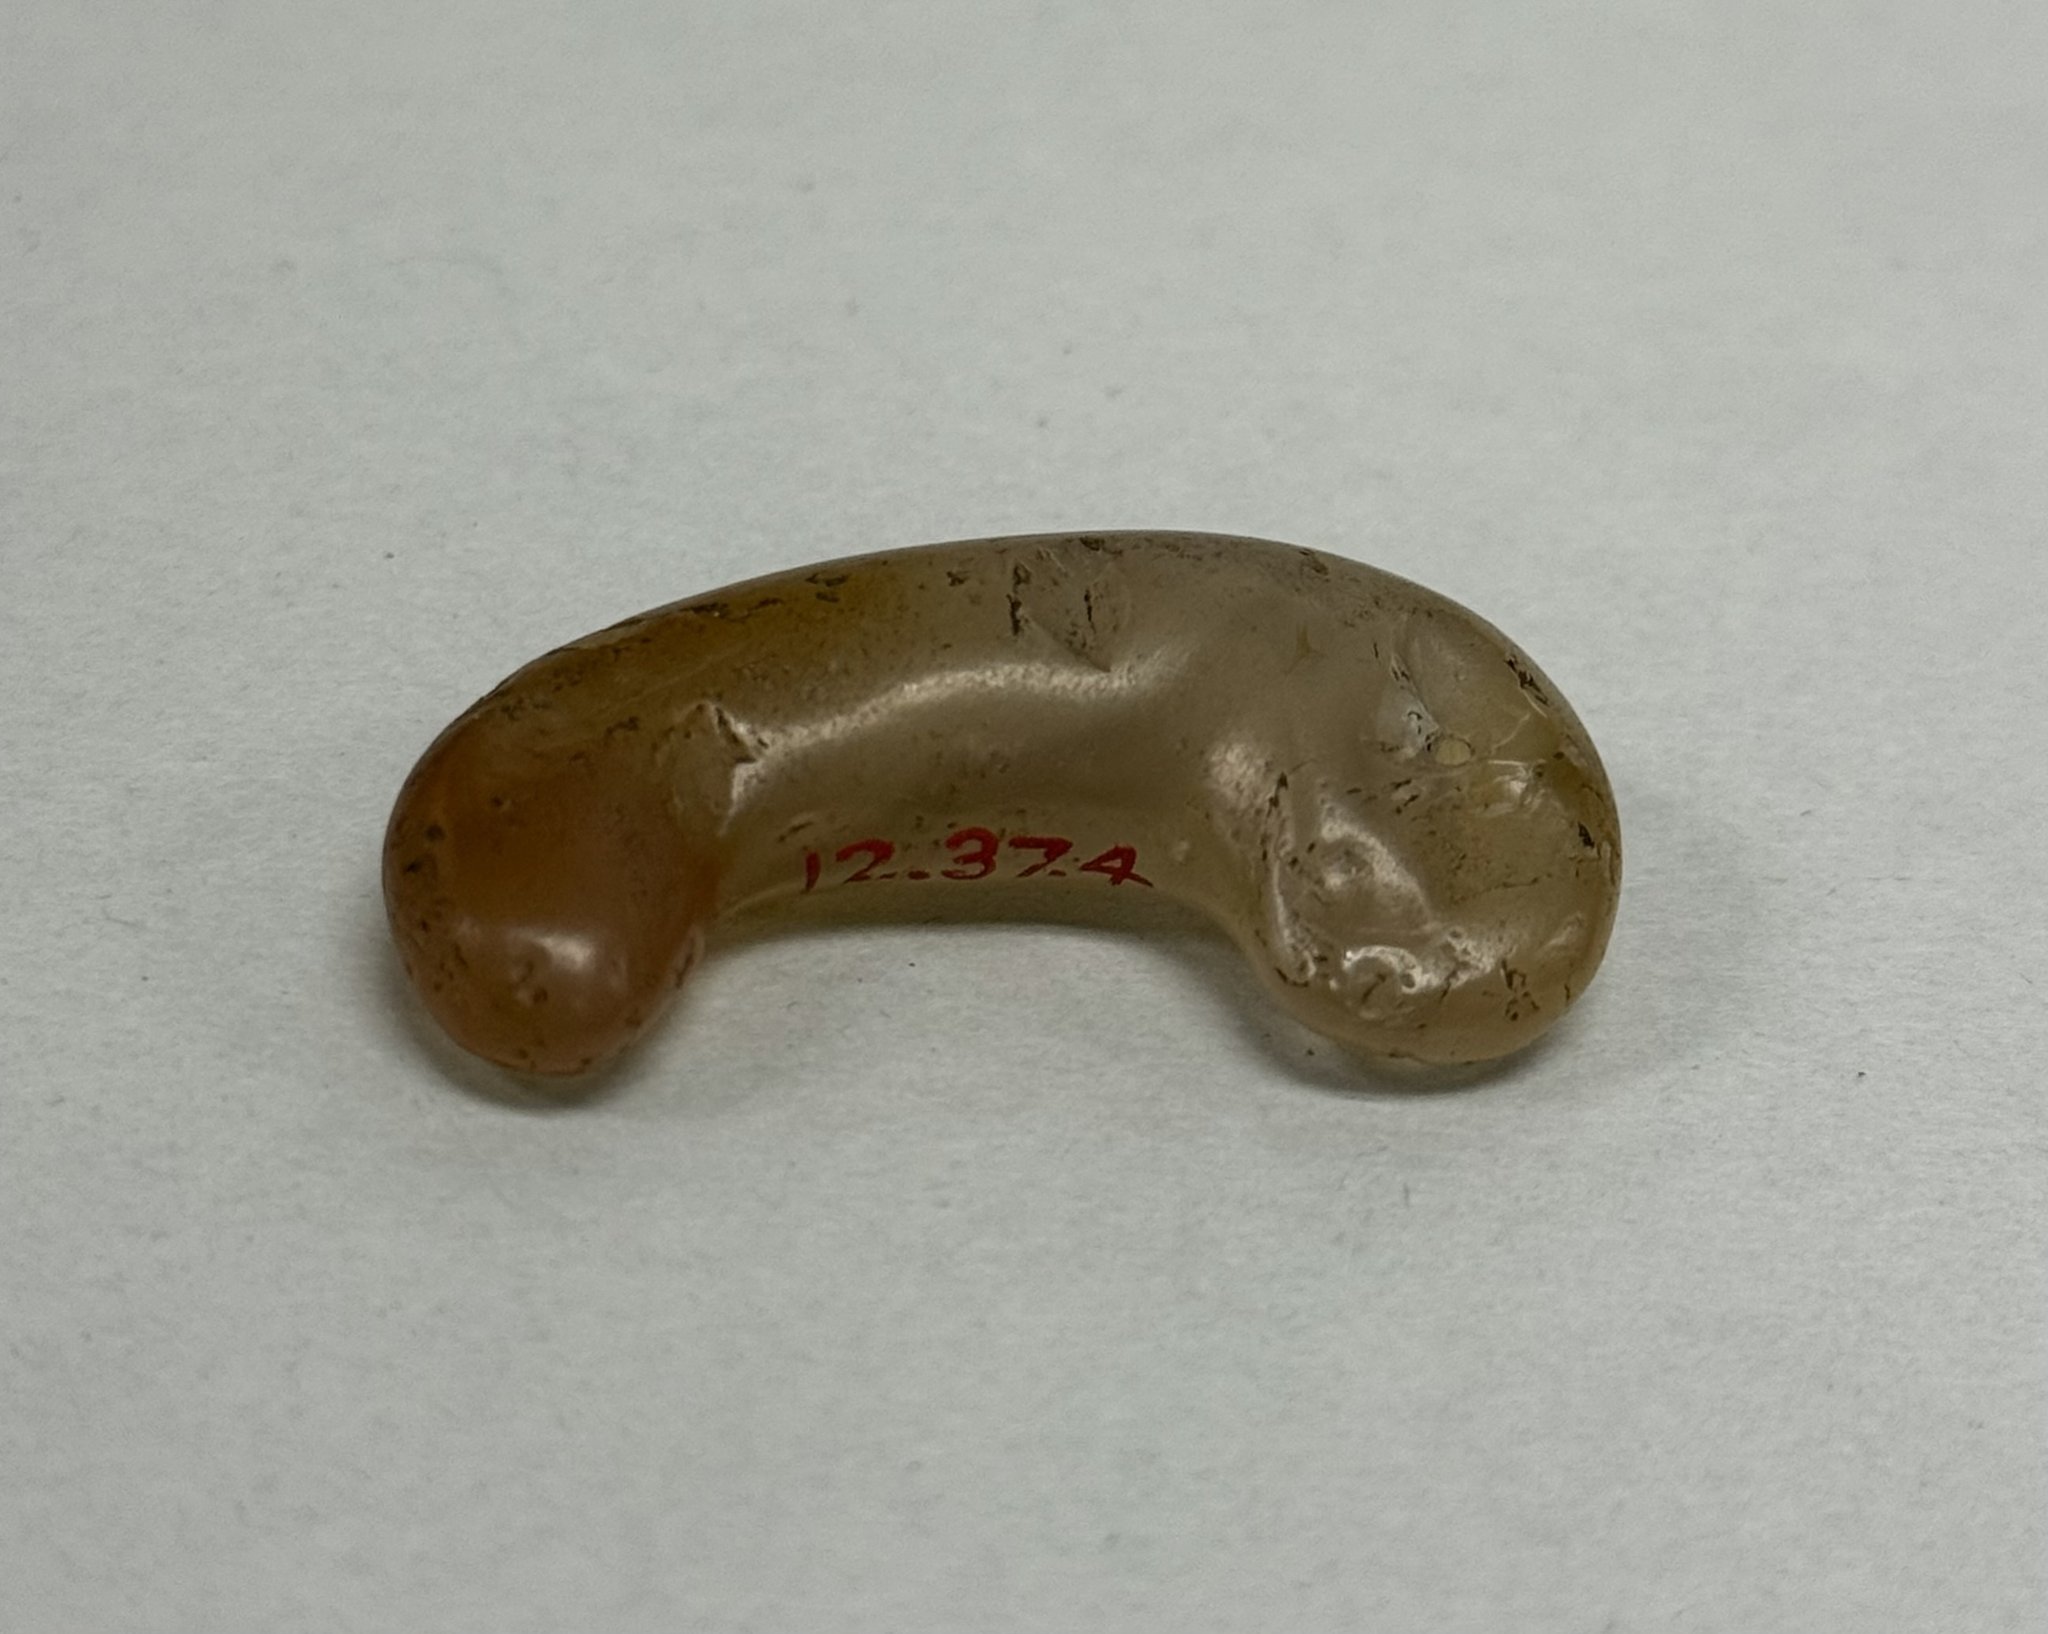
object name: jewel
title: Tiger Claw Jewel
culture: japanese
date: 601-700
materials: stone